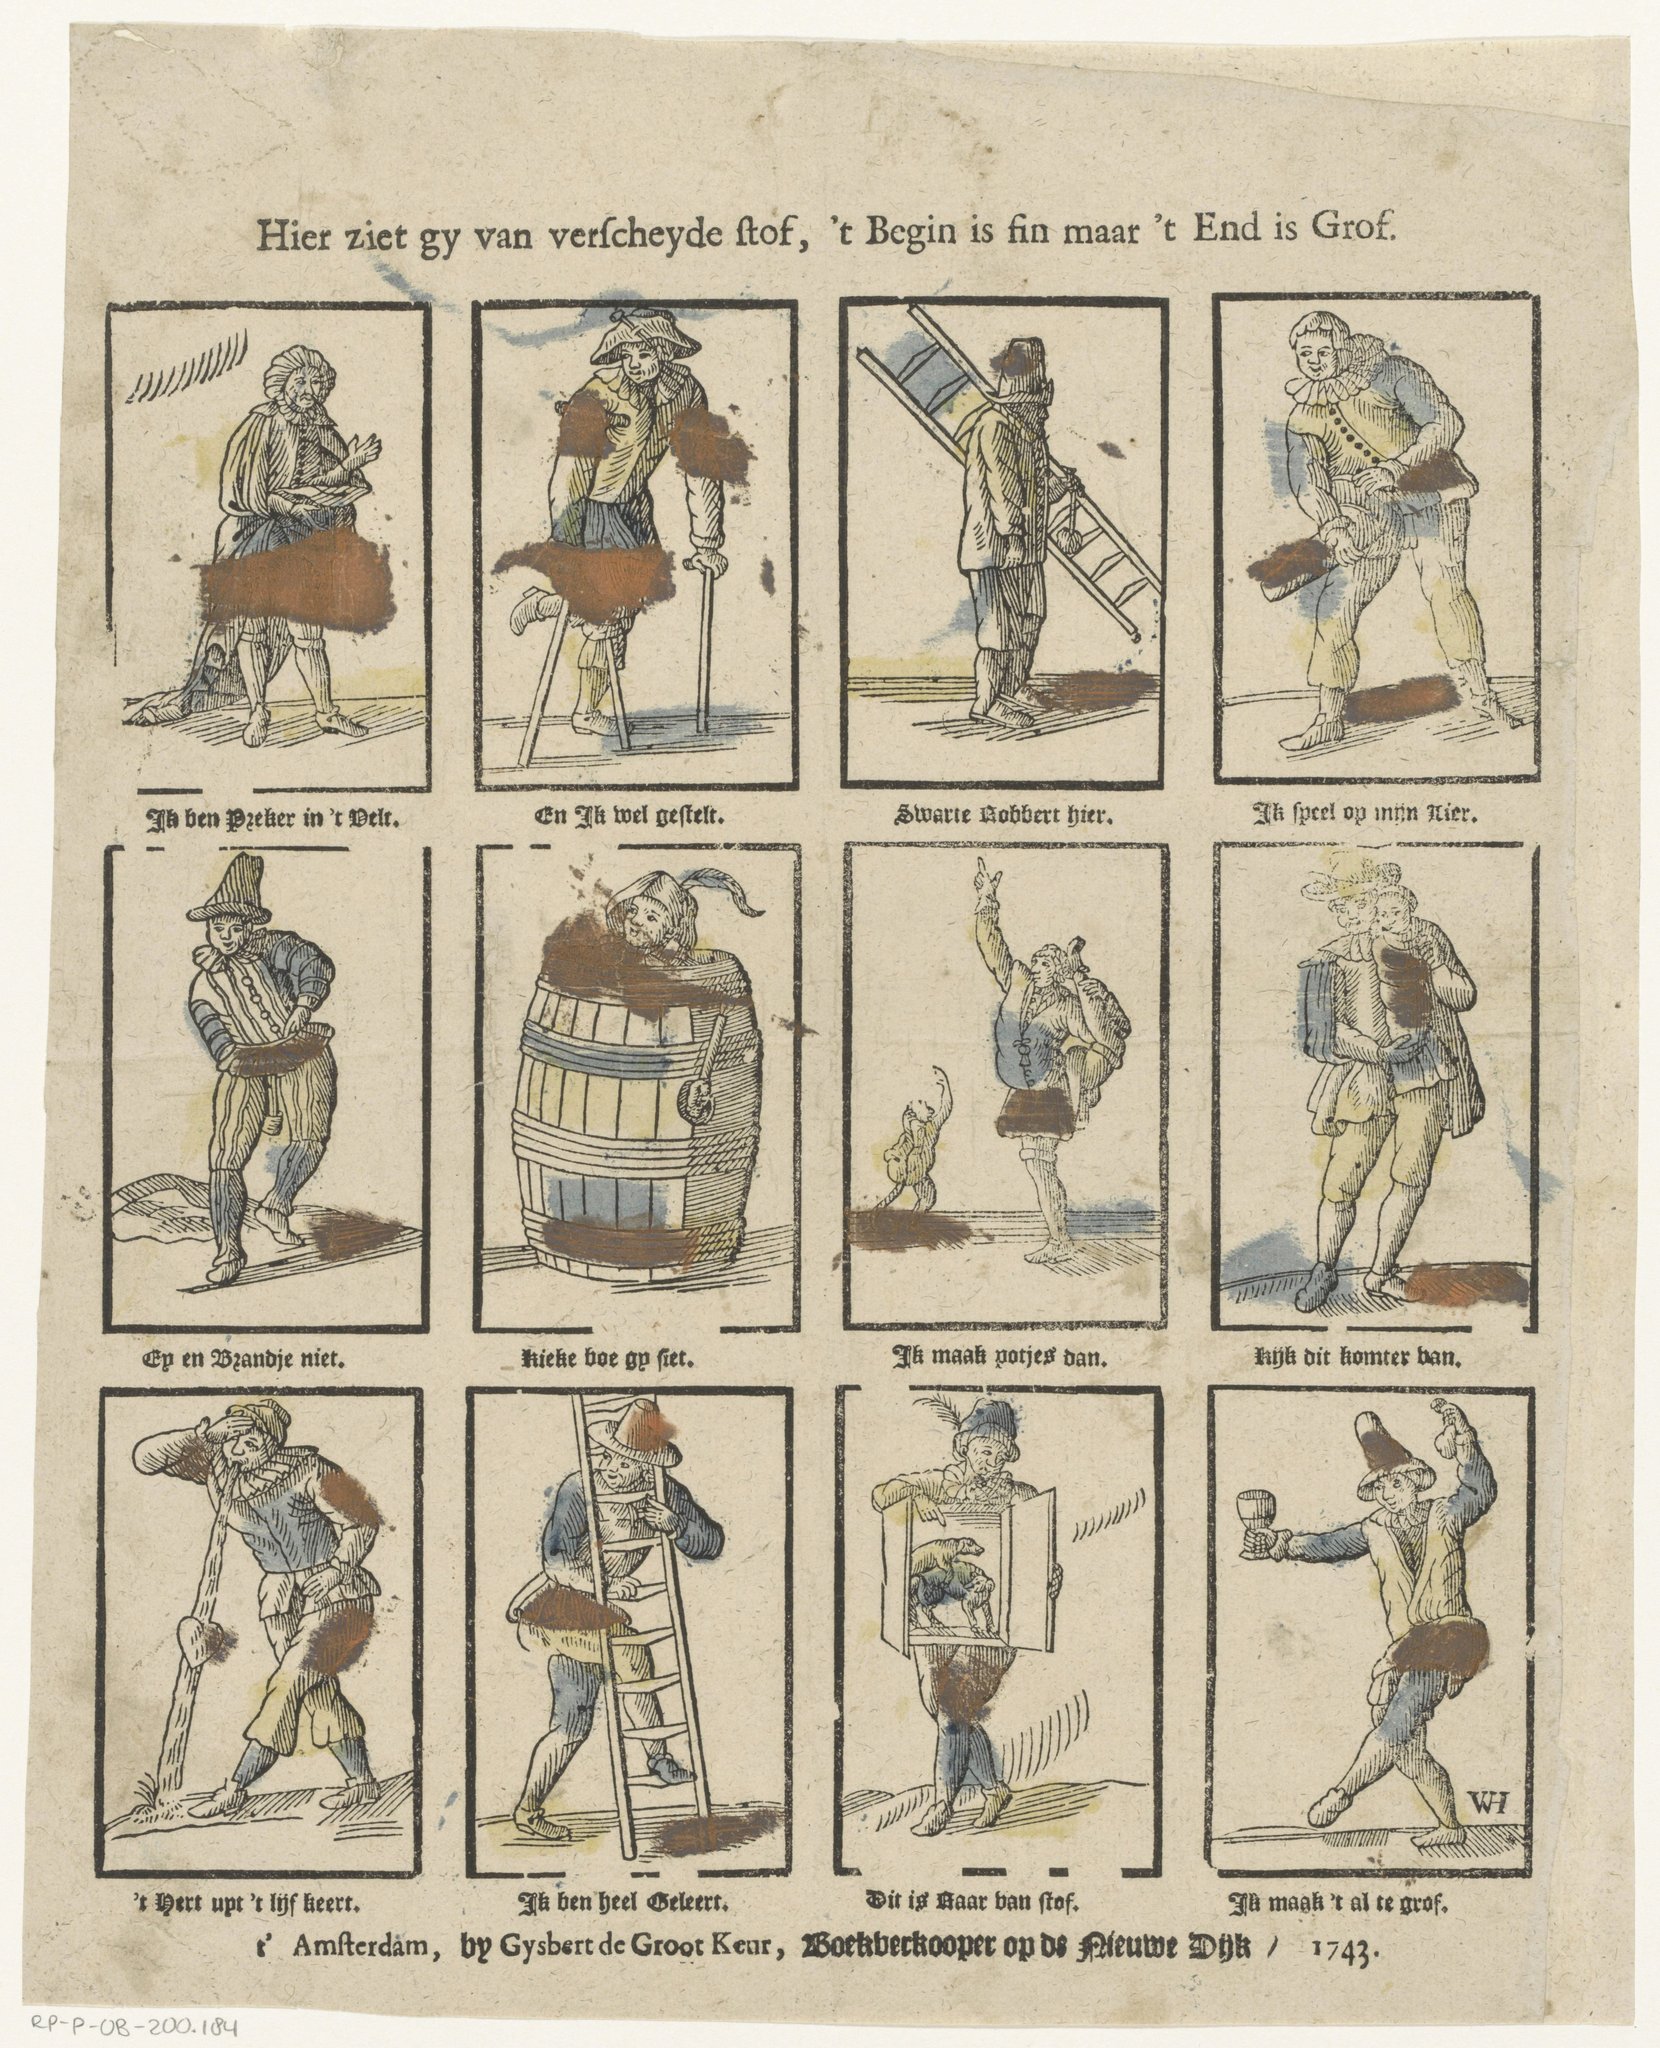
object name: print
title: Hier ziet gy van verscheyde stof, 't begin is fin maar het end in grof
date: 1743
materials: paper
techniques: colour, letterpress printing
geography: amsterdam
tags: drunkard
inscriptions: collector's mark: Lugt 2760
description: Blad met 12 voorstellingen van zotte figuren en uitbeeldingen van gezegden. Onder elke afbeelding een onderschrift.